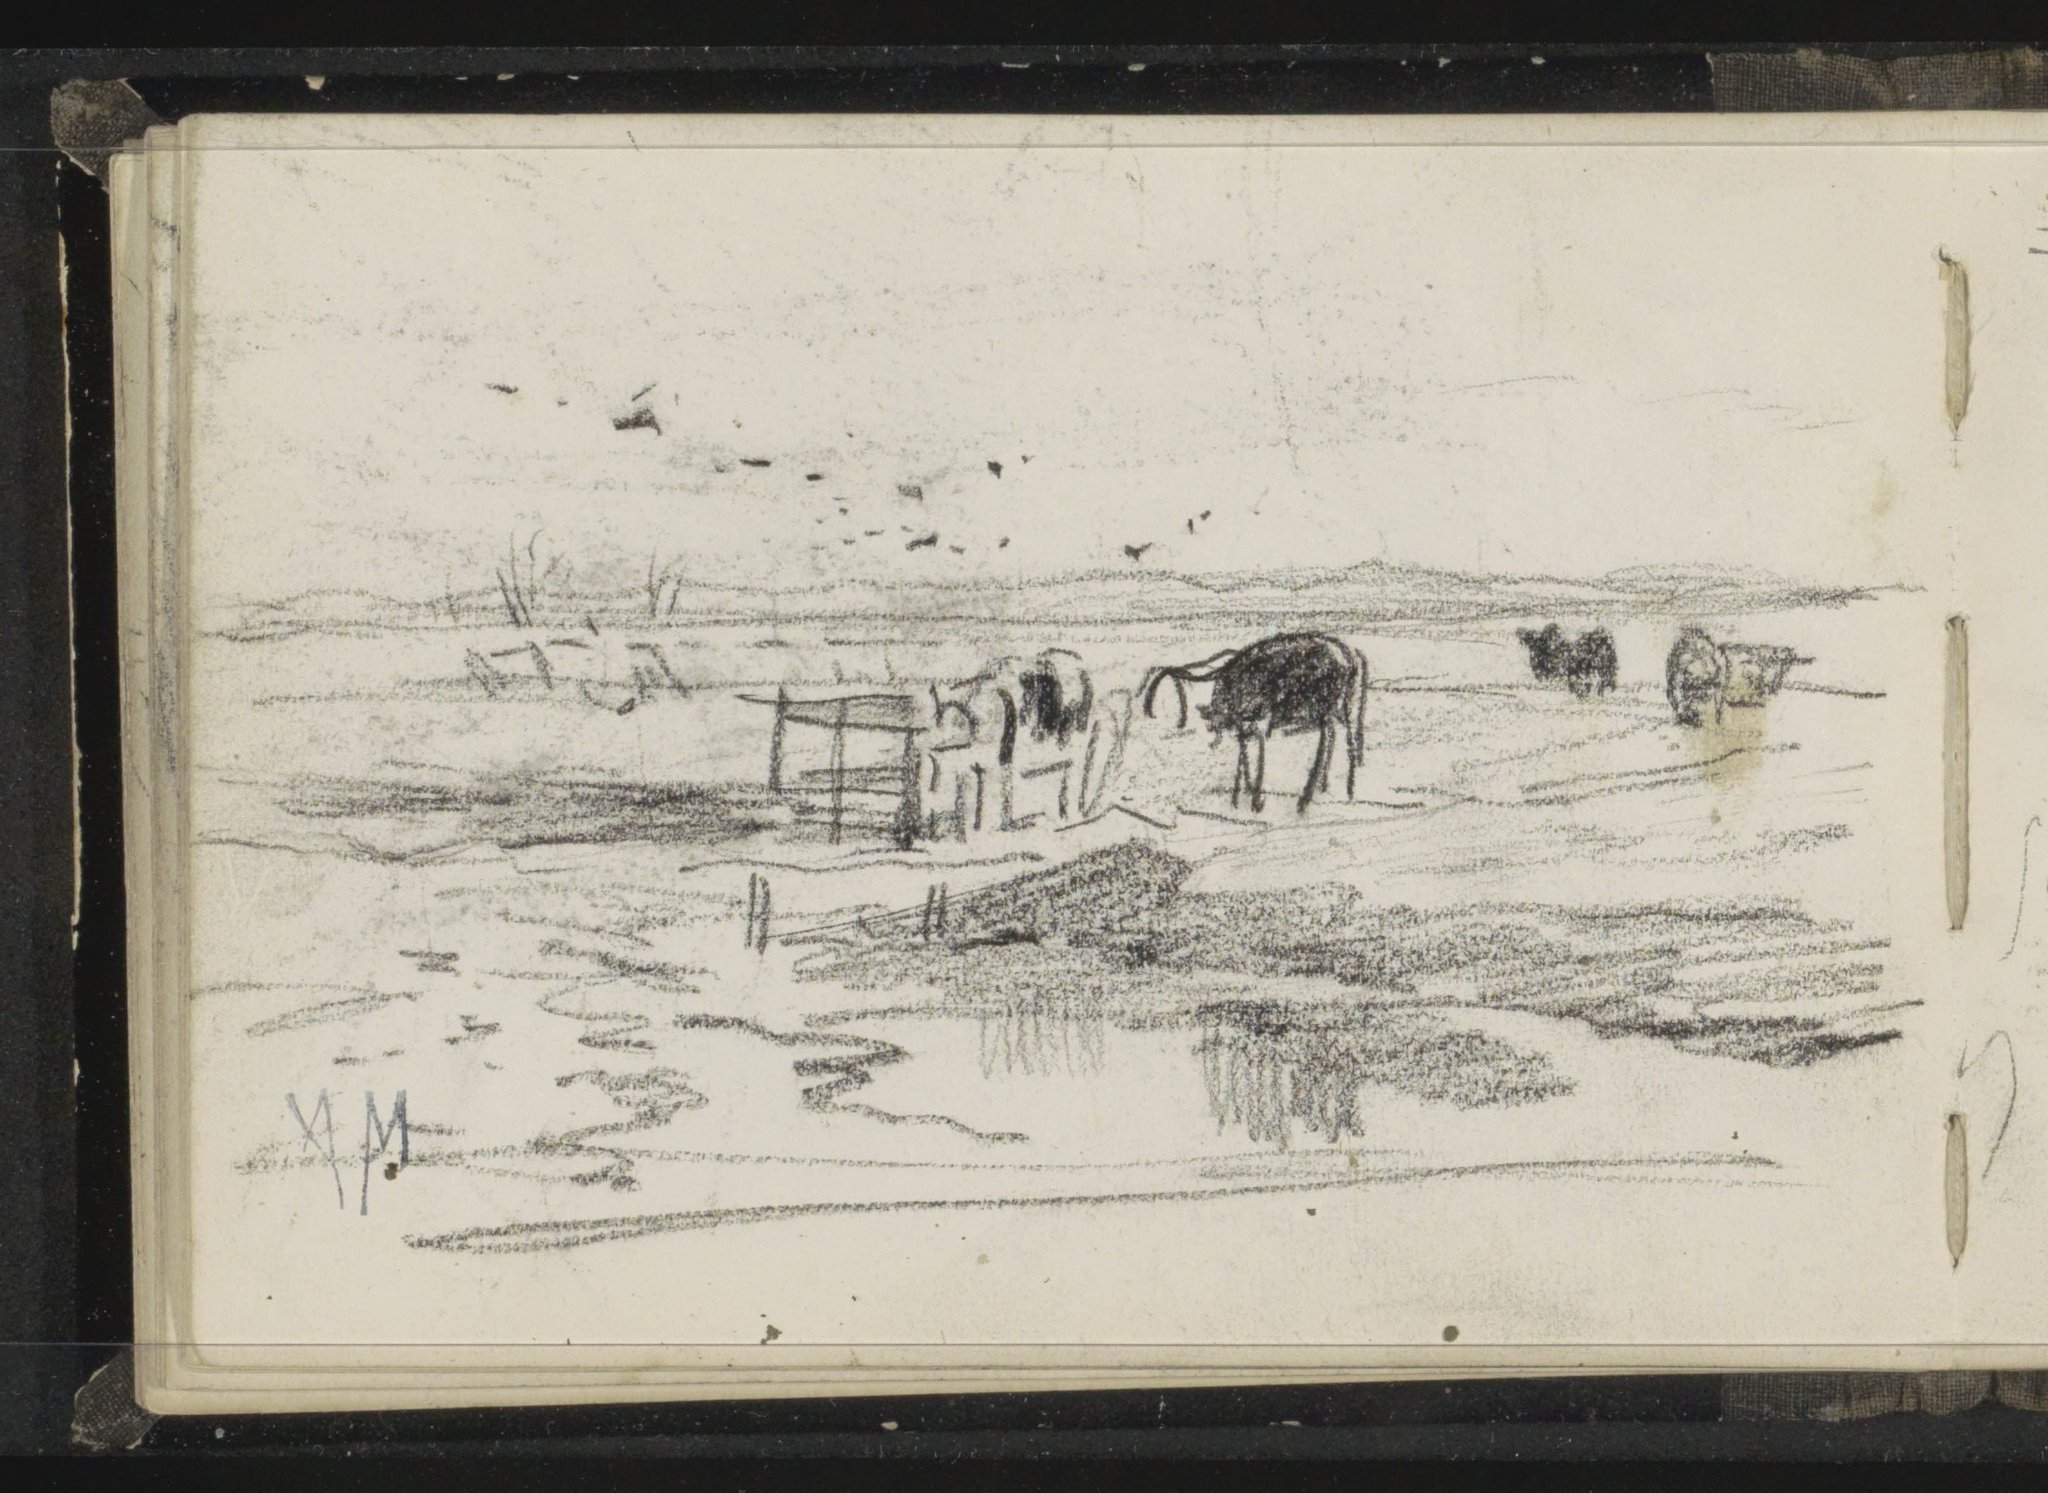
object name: sketchbook leaf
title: Koeien in een weide bij een waterkant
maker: anton mauve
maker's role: draughtsman, painter, print maker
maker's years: 1838-1888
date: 1848-1888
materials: chalk, paper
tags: cow, landscapes with waters, waterscapes, seascapes (in the temperate zone)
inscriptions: monogram: ‘AM’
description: Blad 18 verso uit een schetsboek met 33 bladen.